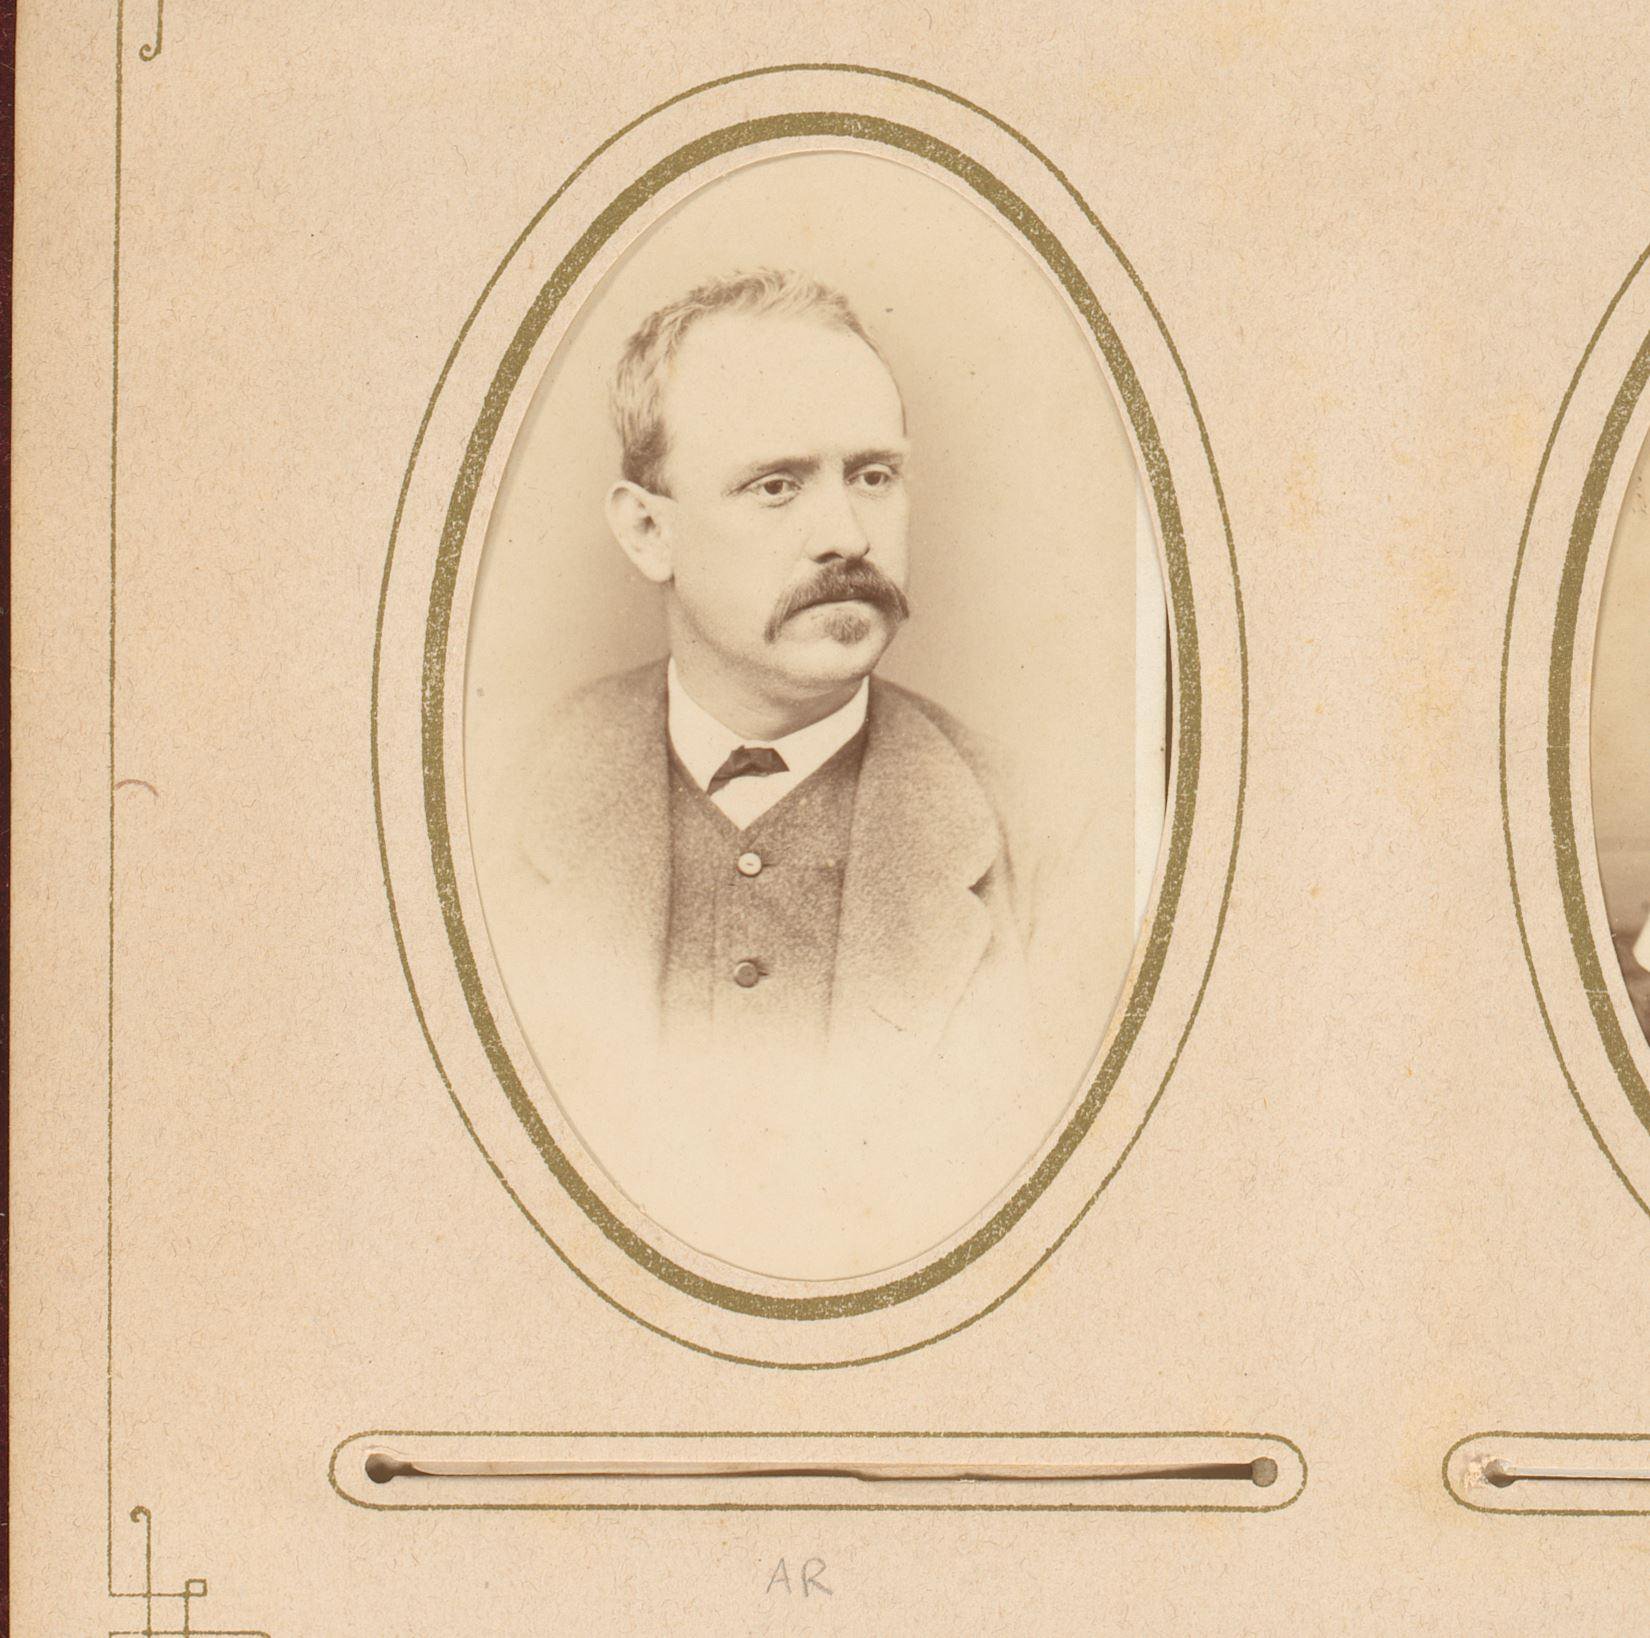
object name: album leaf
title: Portret van een man met snor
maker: corrodi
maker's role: fotograaf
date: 1860-1880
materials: cardboard, photographic support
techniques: albumen print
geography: bern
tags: moustache, historical persons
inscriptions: inscription: ‘Corrodi/ opticien/ BERNE (SUISSE)/ vis-à-vis de la gare.’